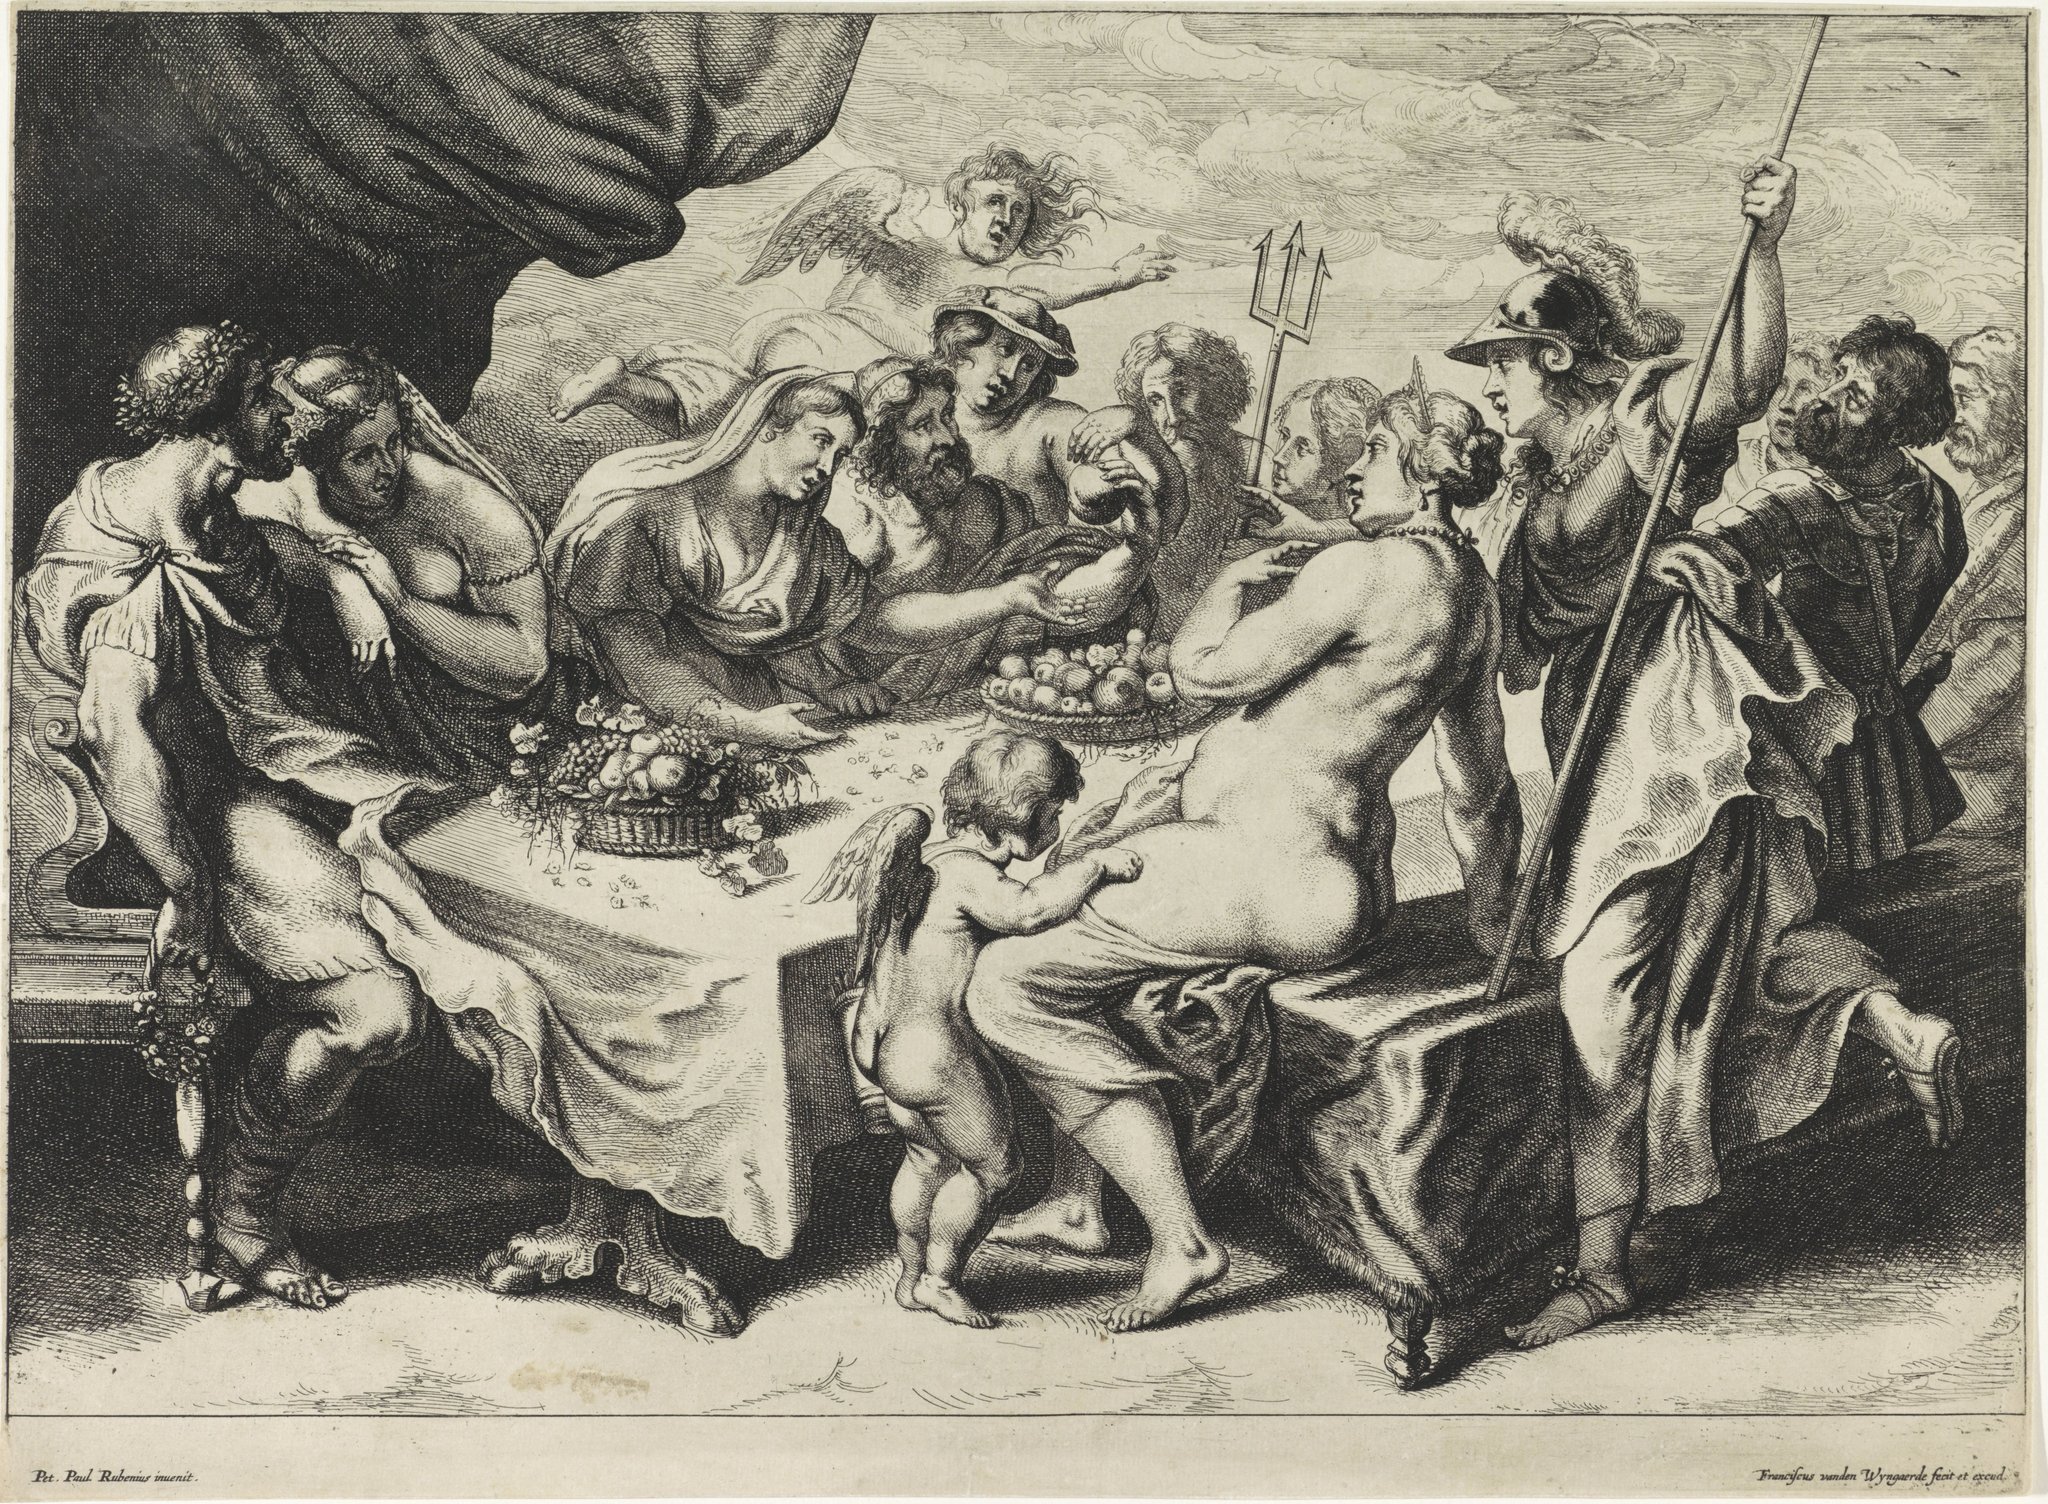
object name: print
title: Huwelijk van Peleus en Thetis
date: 1636-1679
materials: paper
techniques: engraving, etching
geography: antwerp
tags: marriage of peleus and thetis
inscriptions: collector's mark: Lugt 240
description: Peleus en Thetis zitten aan tafel met de goden van de Olympus tijdens hun bruiloftsmaal. Twee manden met fruit staan op tafel. Mercurius heeft zojuist de appel voor de mooiste godin gebracht.